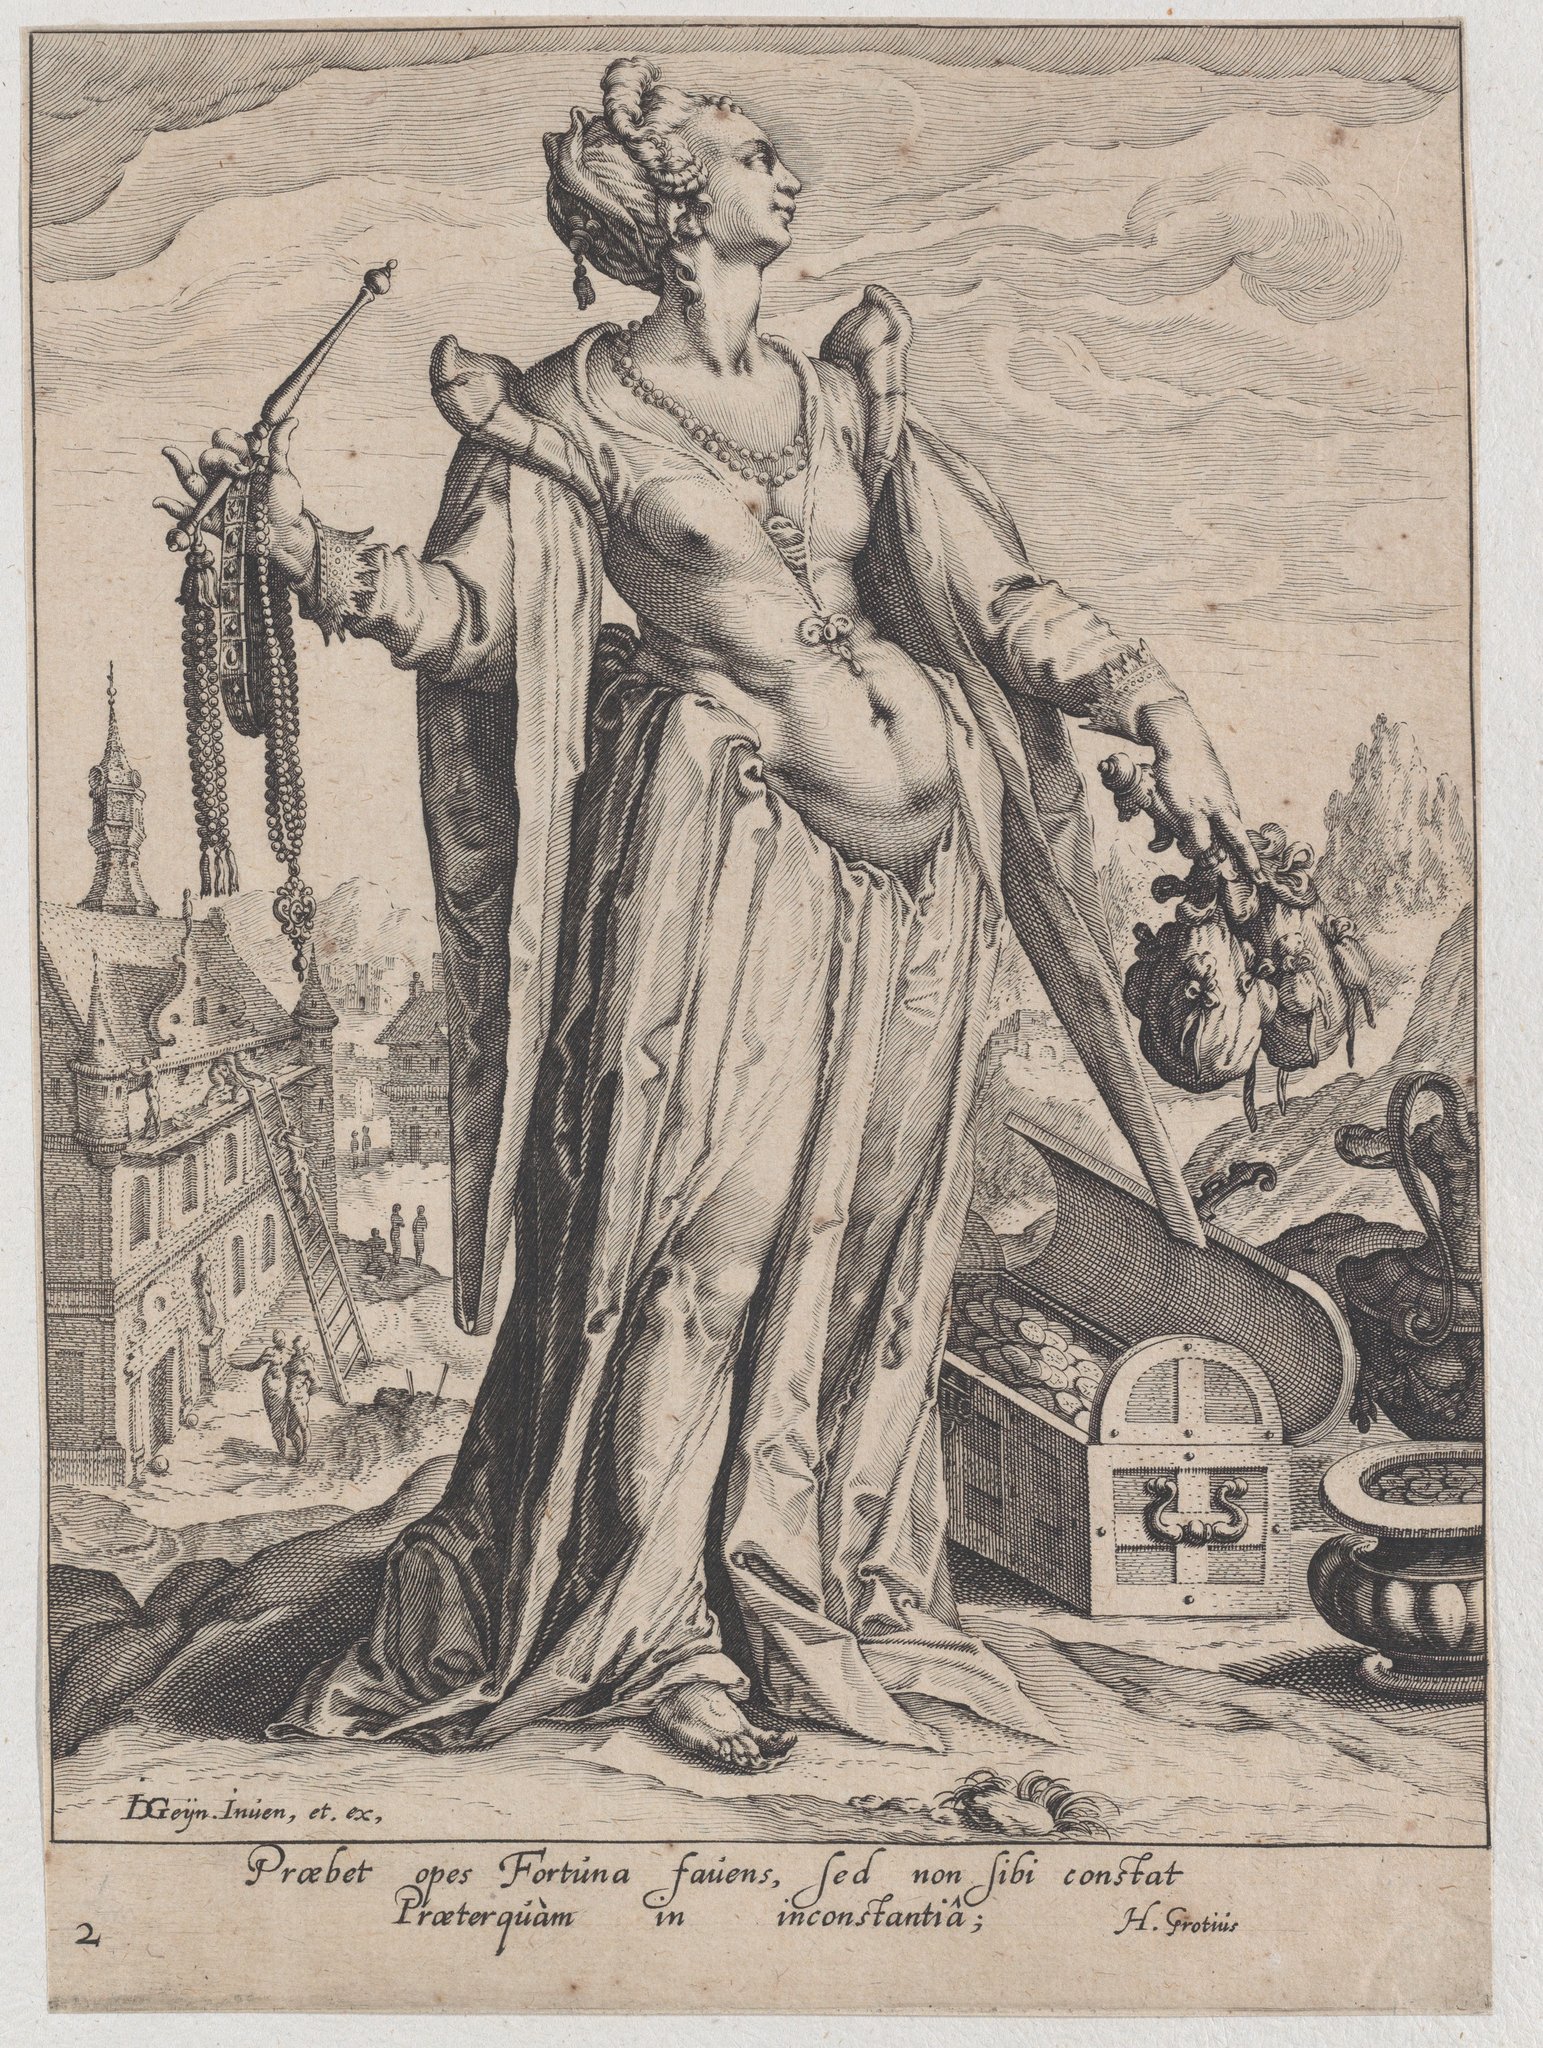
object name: print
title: Wealth, from "Virtues and Vices"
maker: zacharias dolendo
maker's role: artist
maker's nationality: netherlandish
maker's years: 1561-1604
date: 1596-1597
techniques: engraving